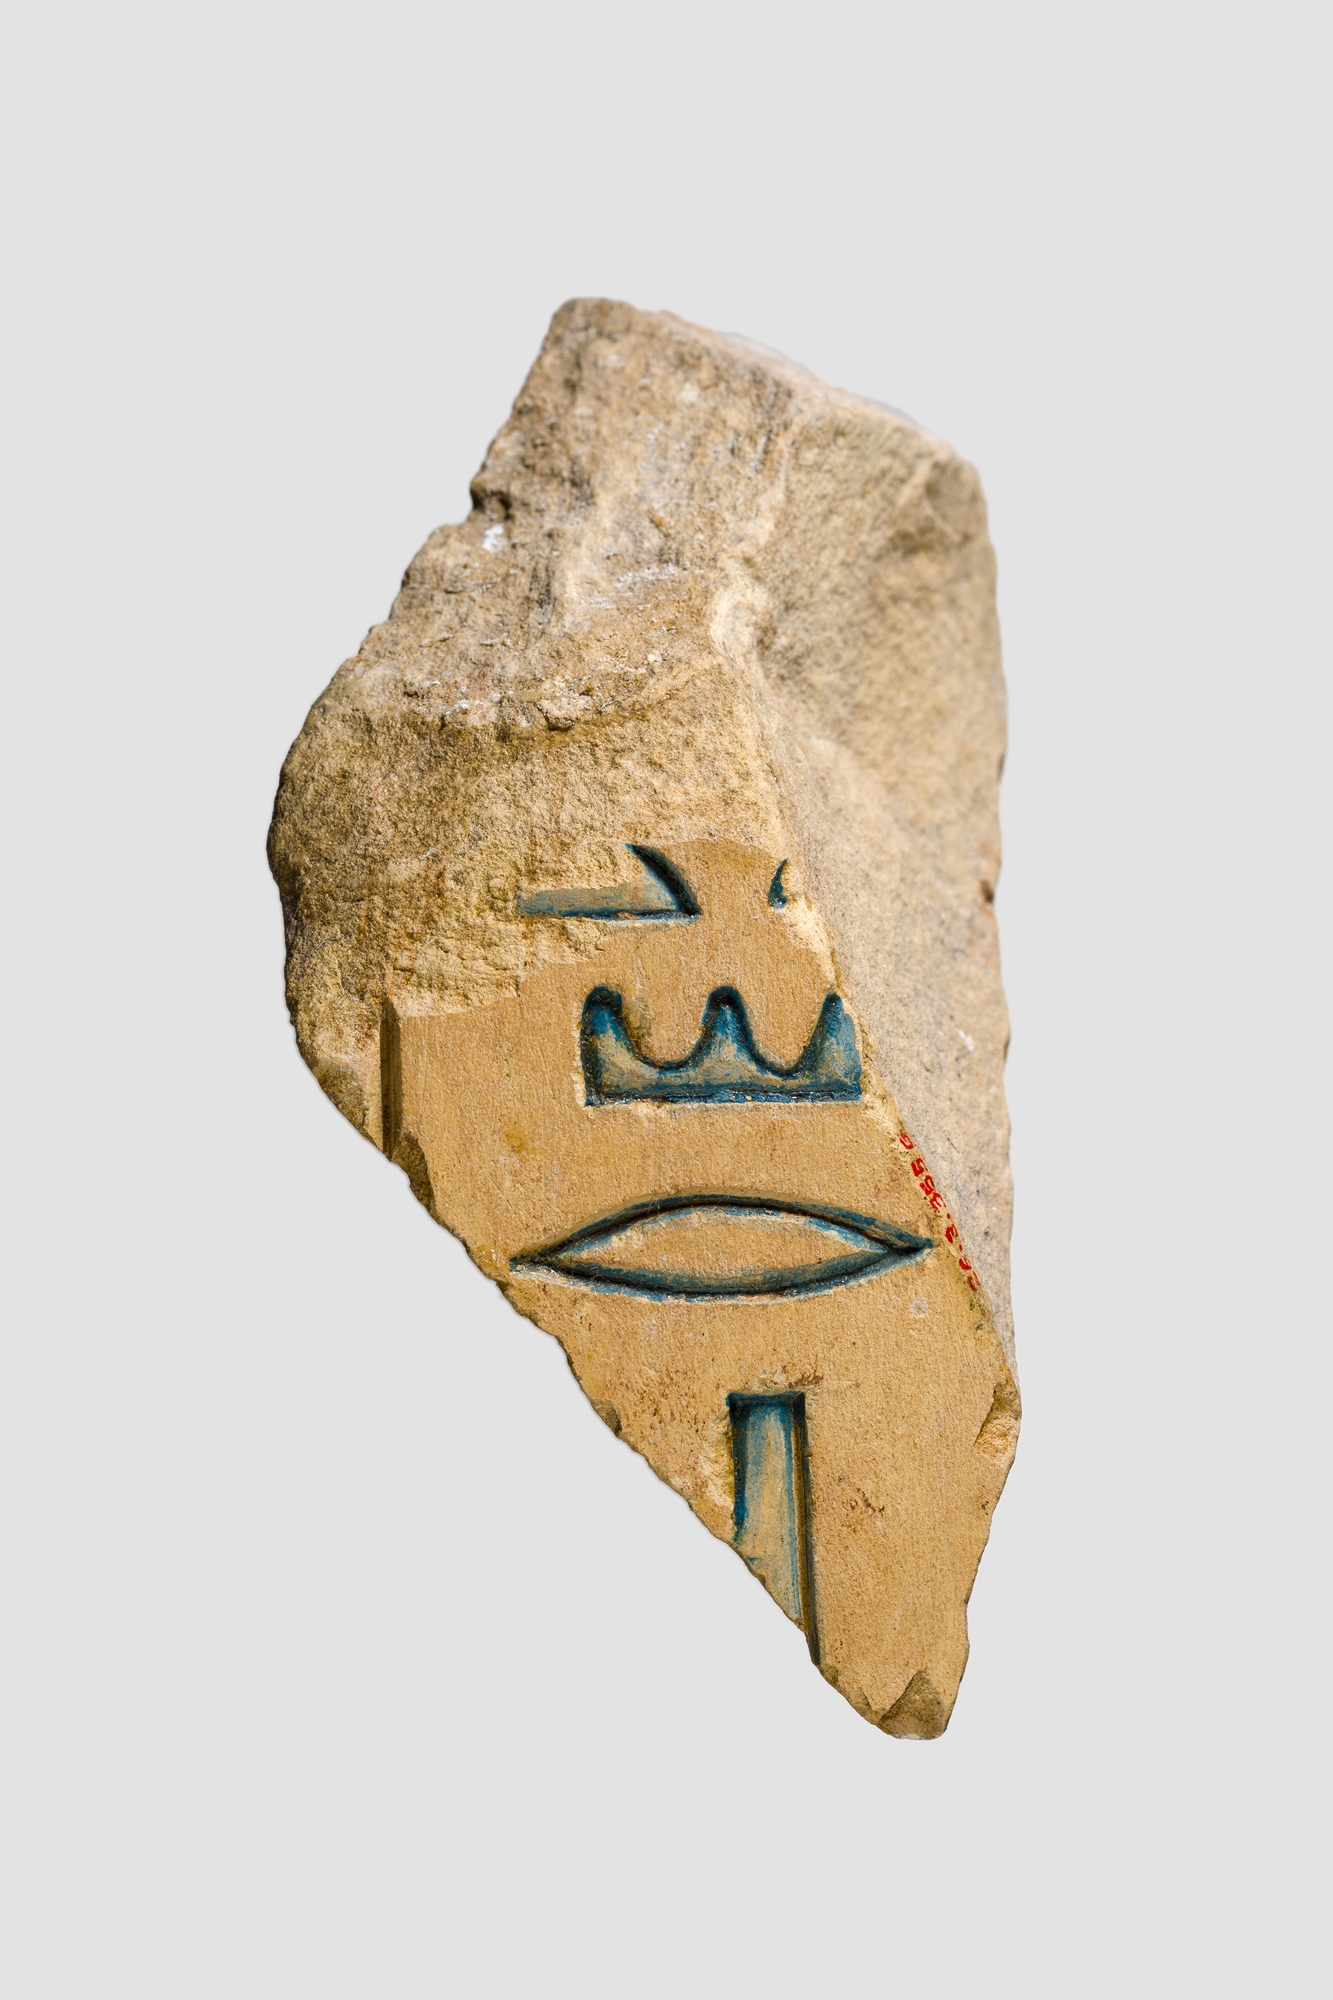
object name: relief fragment, khety, text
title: Relief Fragment of Khety, from Inscription in Sculptured Corridor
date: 2030-1640 BCE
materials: limestone, paint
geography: egypt